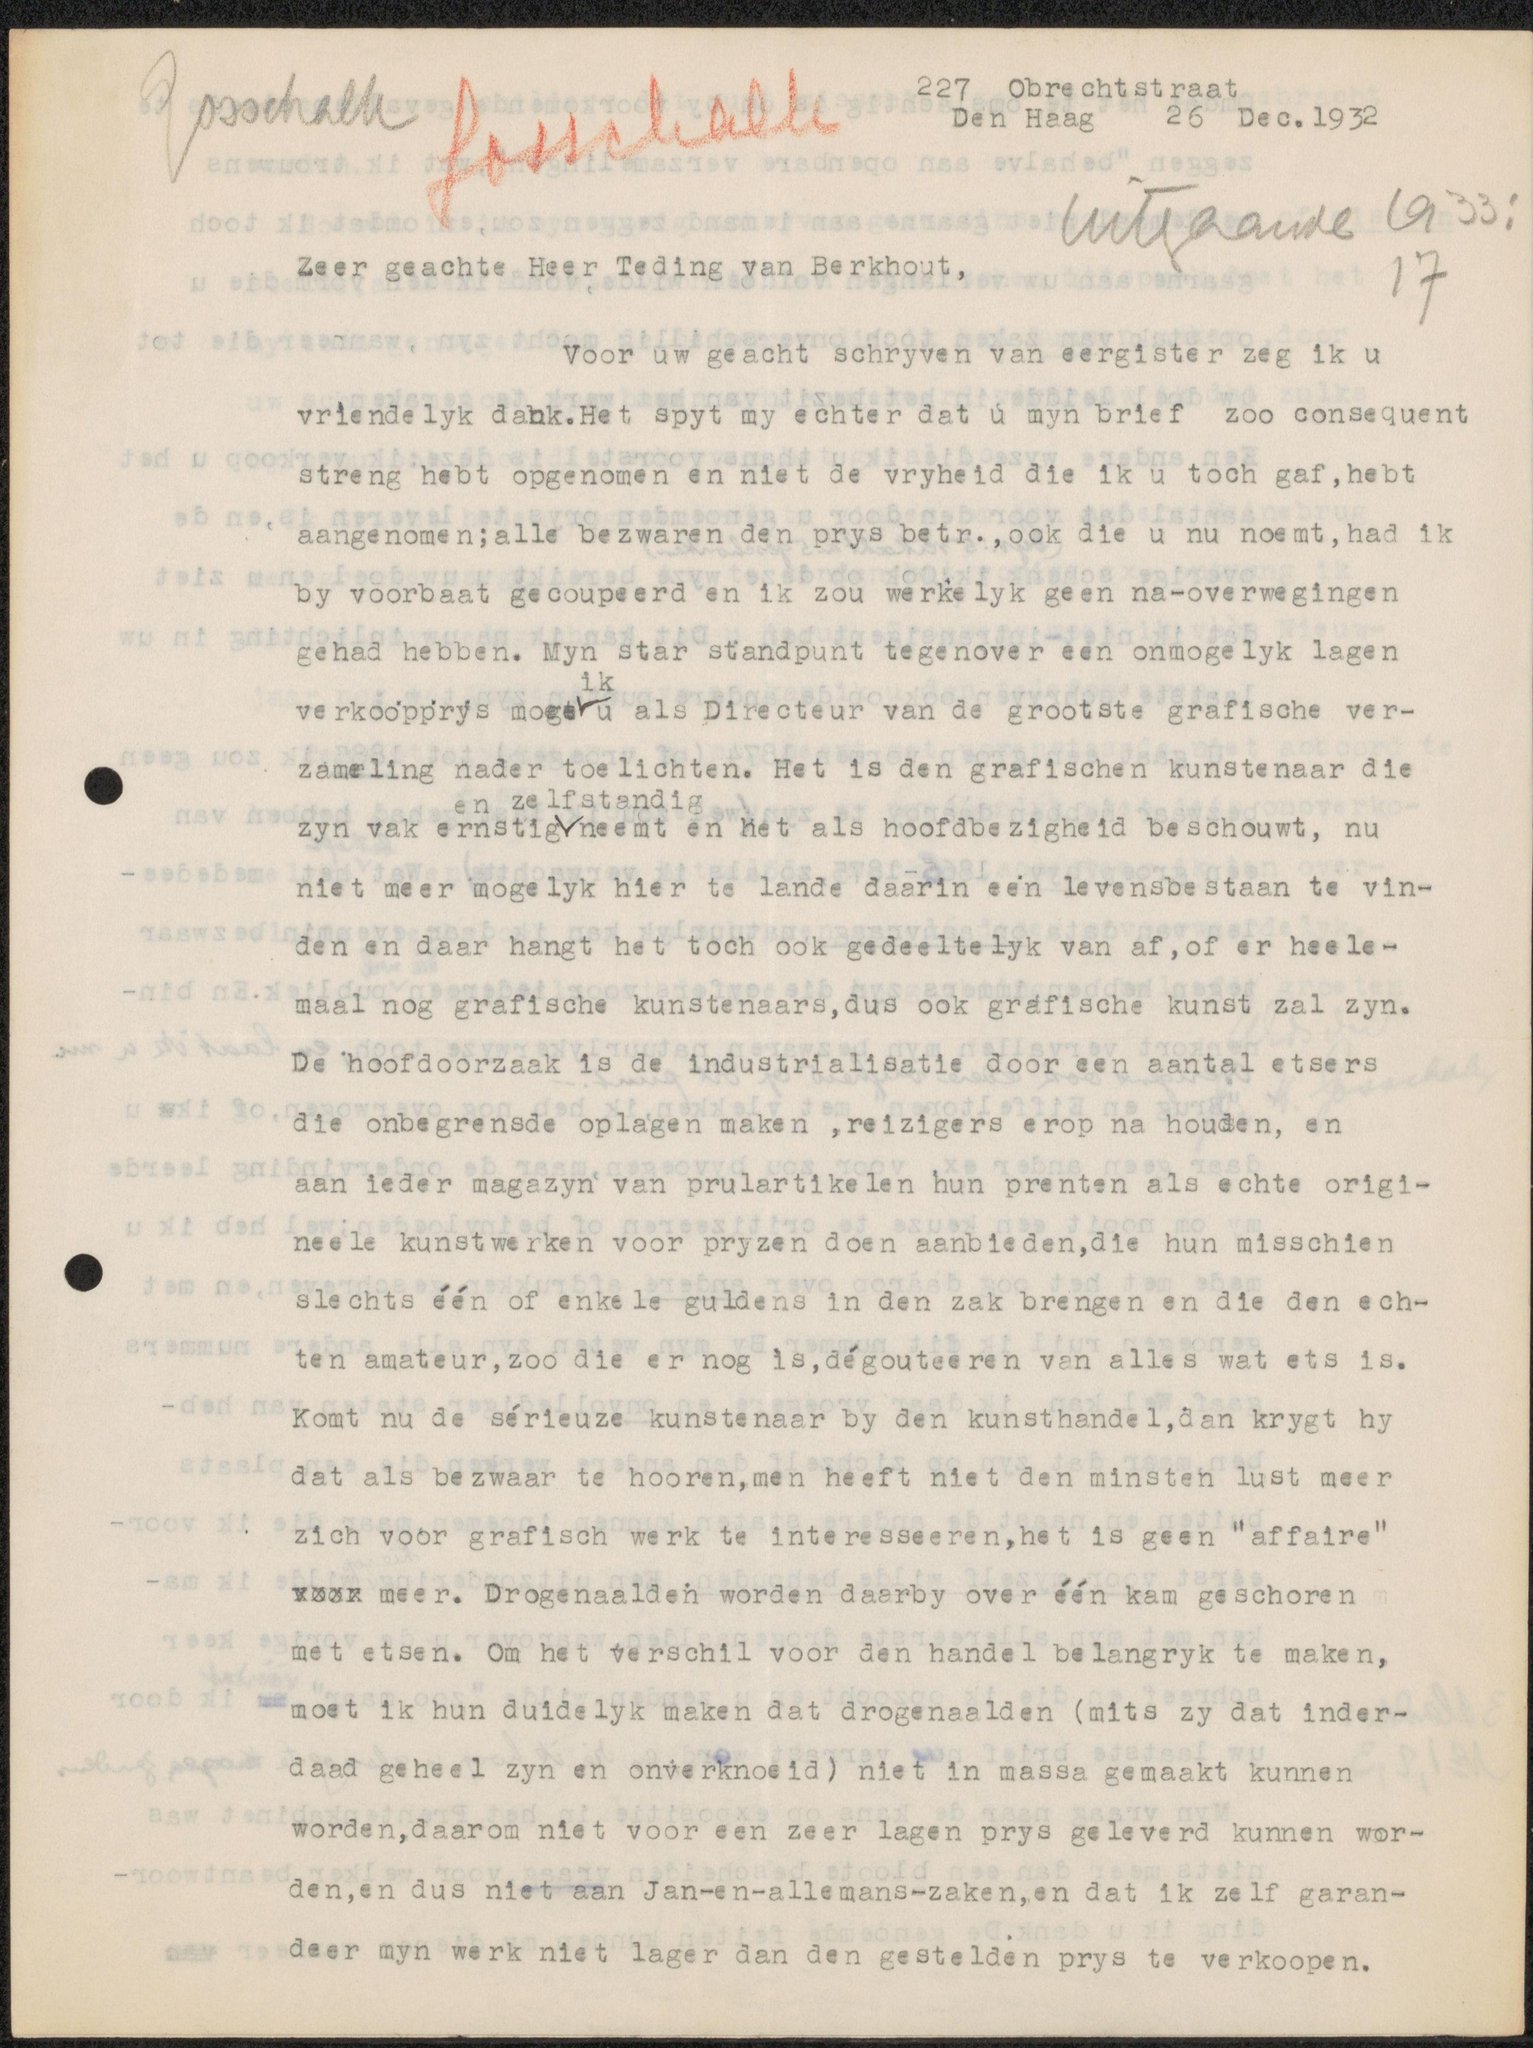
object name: letter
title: Brief aan jonkheer Hendrik Teding van Berkhout (1879-1969)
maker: joseph henry gosschalk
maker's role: draughtsman, print maker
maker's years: 1875-1952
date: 1932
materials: ink, paper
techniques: pen, typewriting, writing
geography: the hague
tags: print room, haarlem, amsterdam, jonkheer hendrik teding van berkhout (1879-1969), the graphic arts, exhibition ~ art, art collecting, money